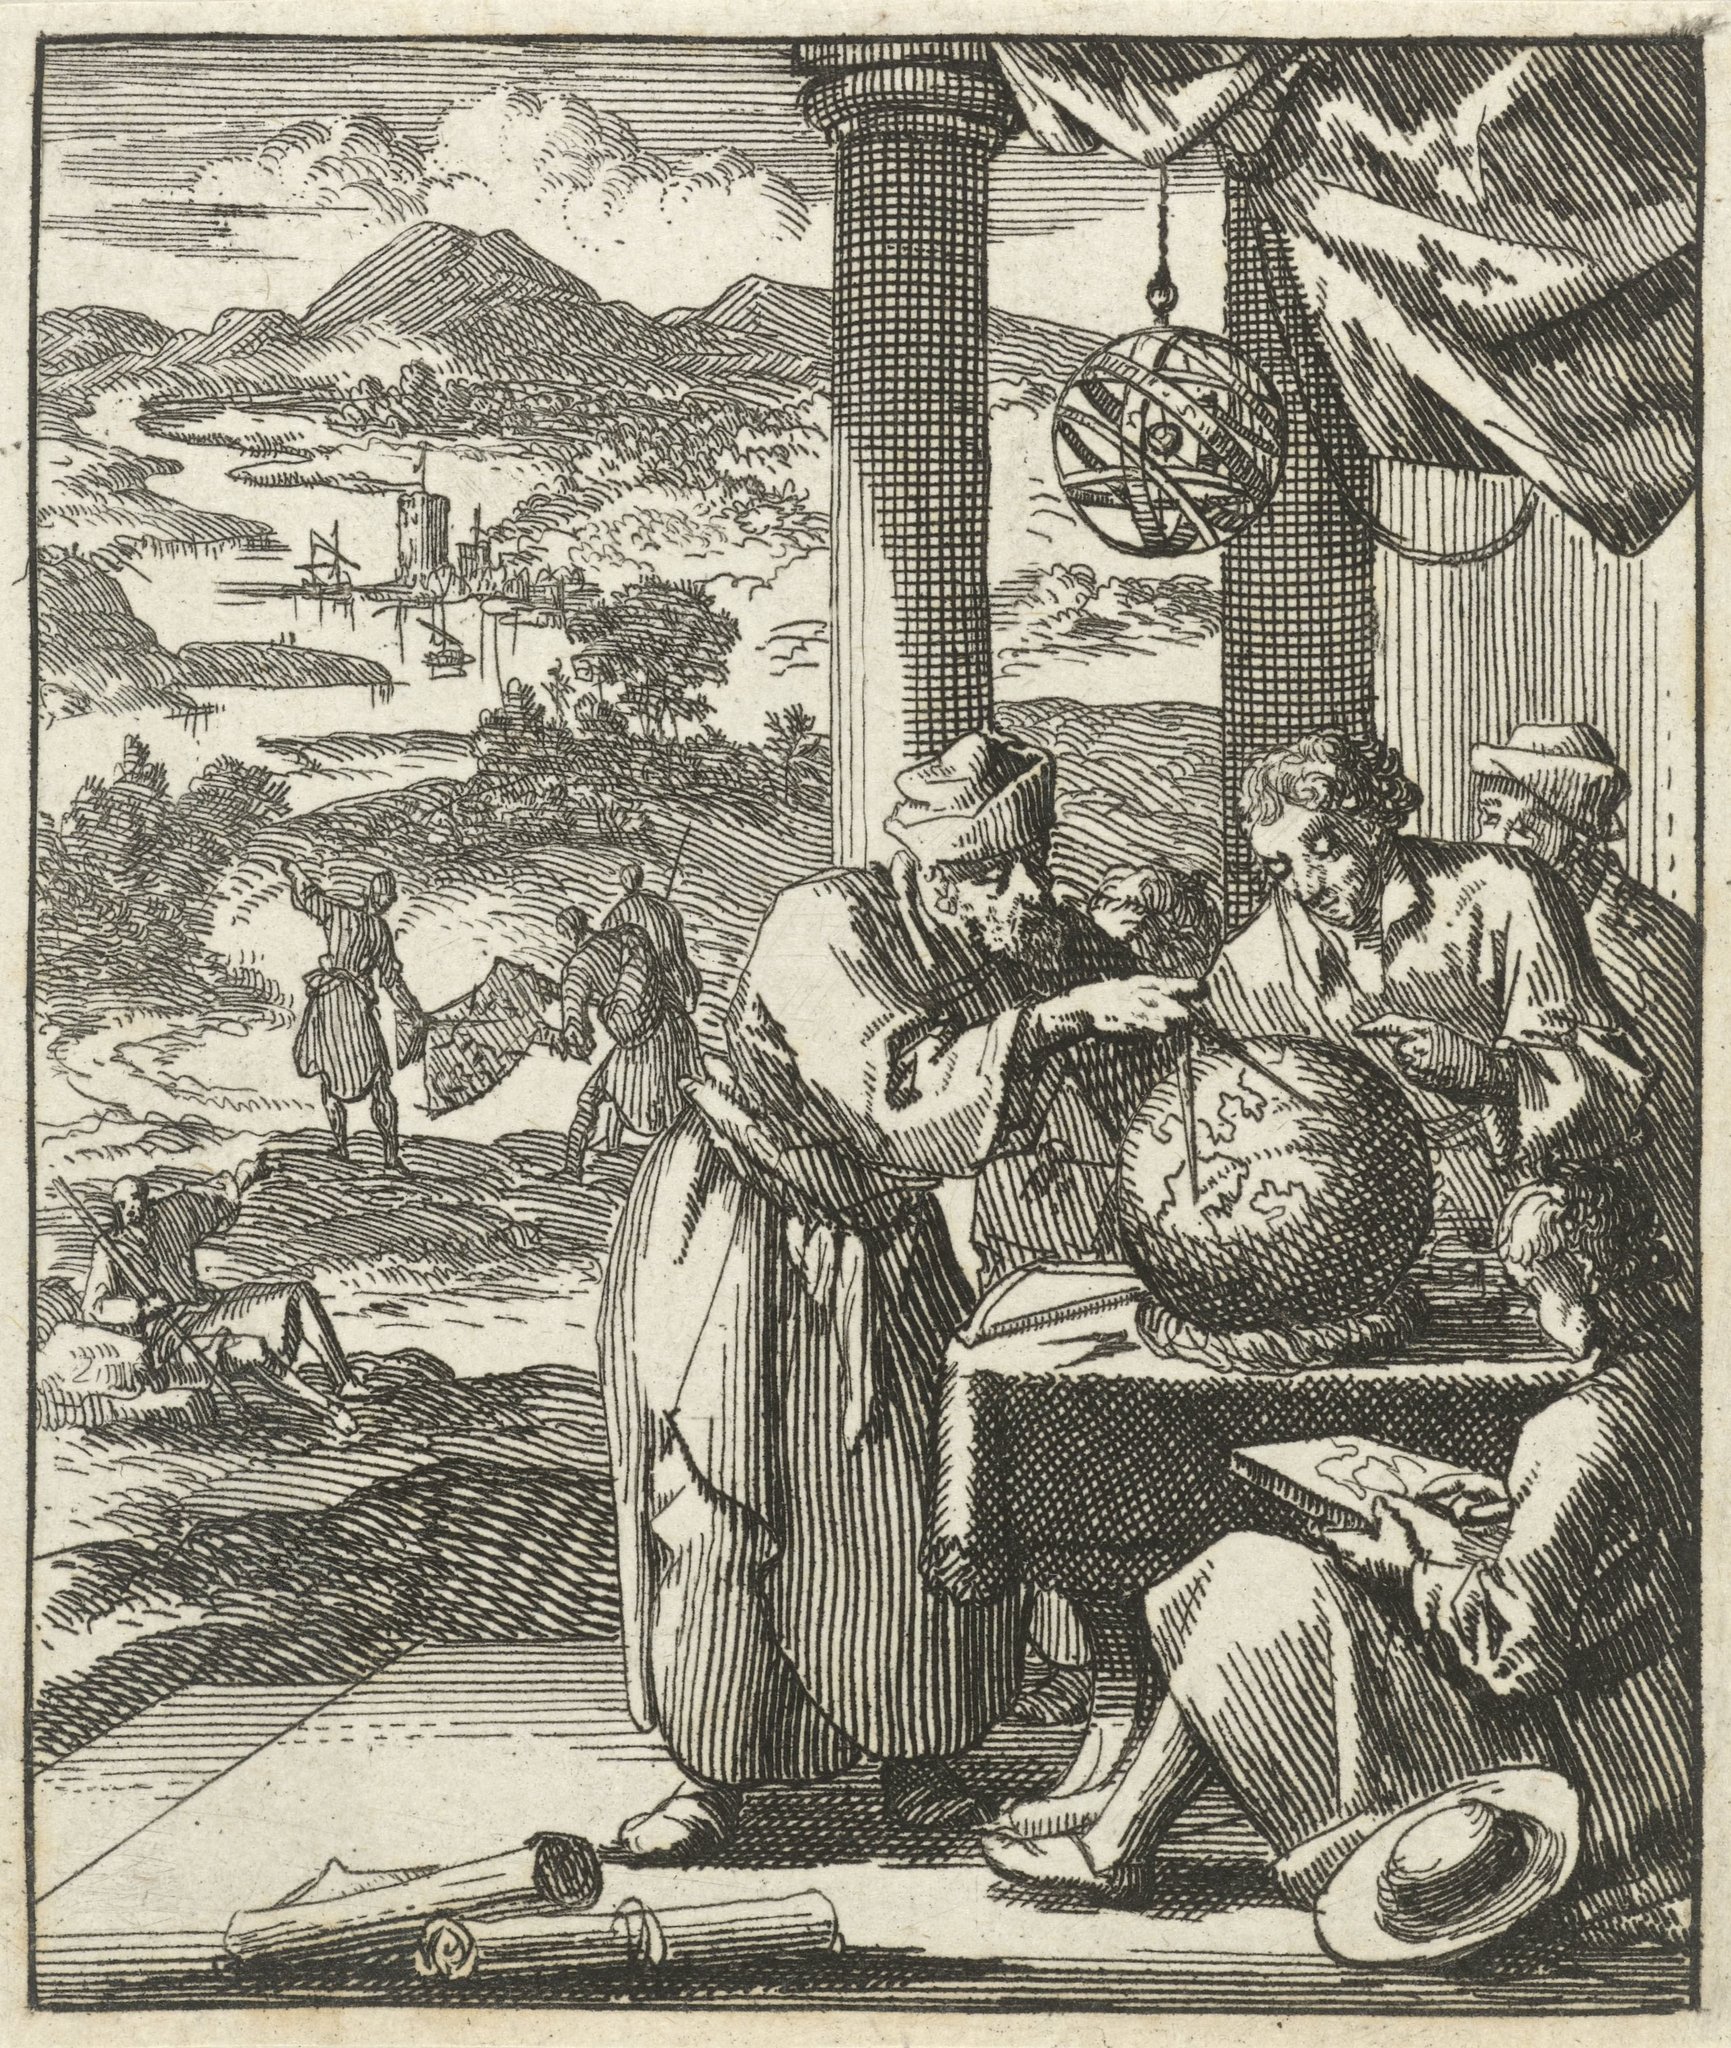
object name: book illustration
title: Bejaarde man maakt voor een viertal jonge figuren afmetingen op een aardglobe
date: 1689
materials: paper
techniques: etching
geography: amsterdam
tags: measuring-instruments (+ scholar, scientist (at work)), sphere, globe ~ stereometry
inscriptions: collector's mark: Lugt 2228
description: Illustratie uit: Huygen, Pieter. De beginselen van Gods koninkryk in den mensch uitgedrukt in zinnebeelden. Amsterdam: wed. Arentsz. Pieter (II), 1689, p. 68.